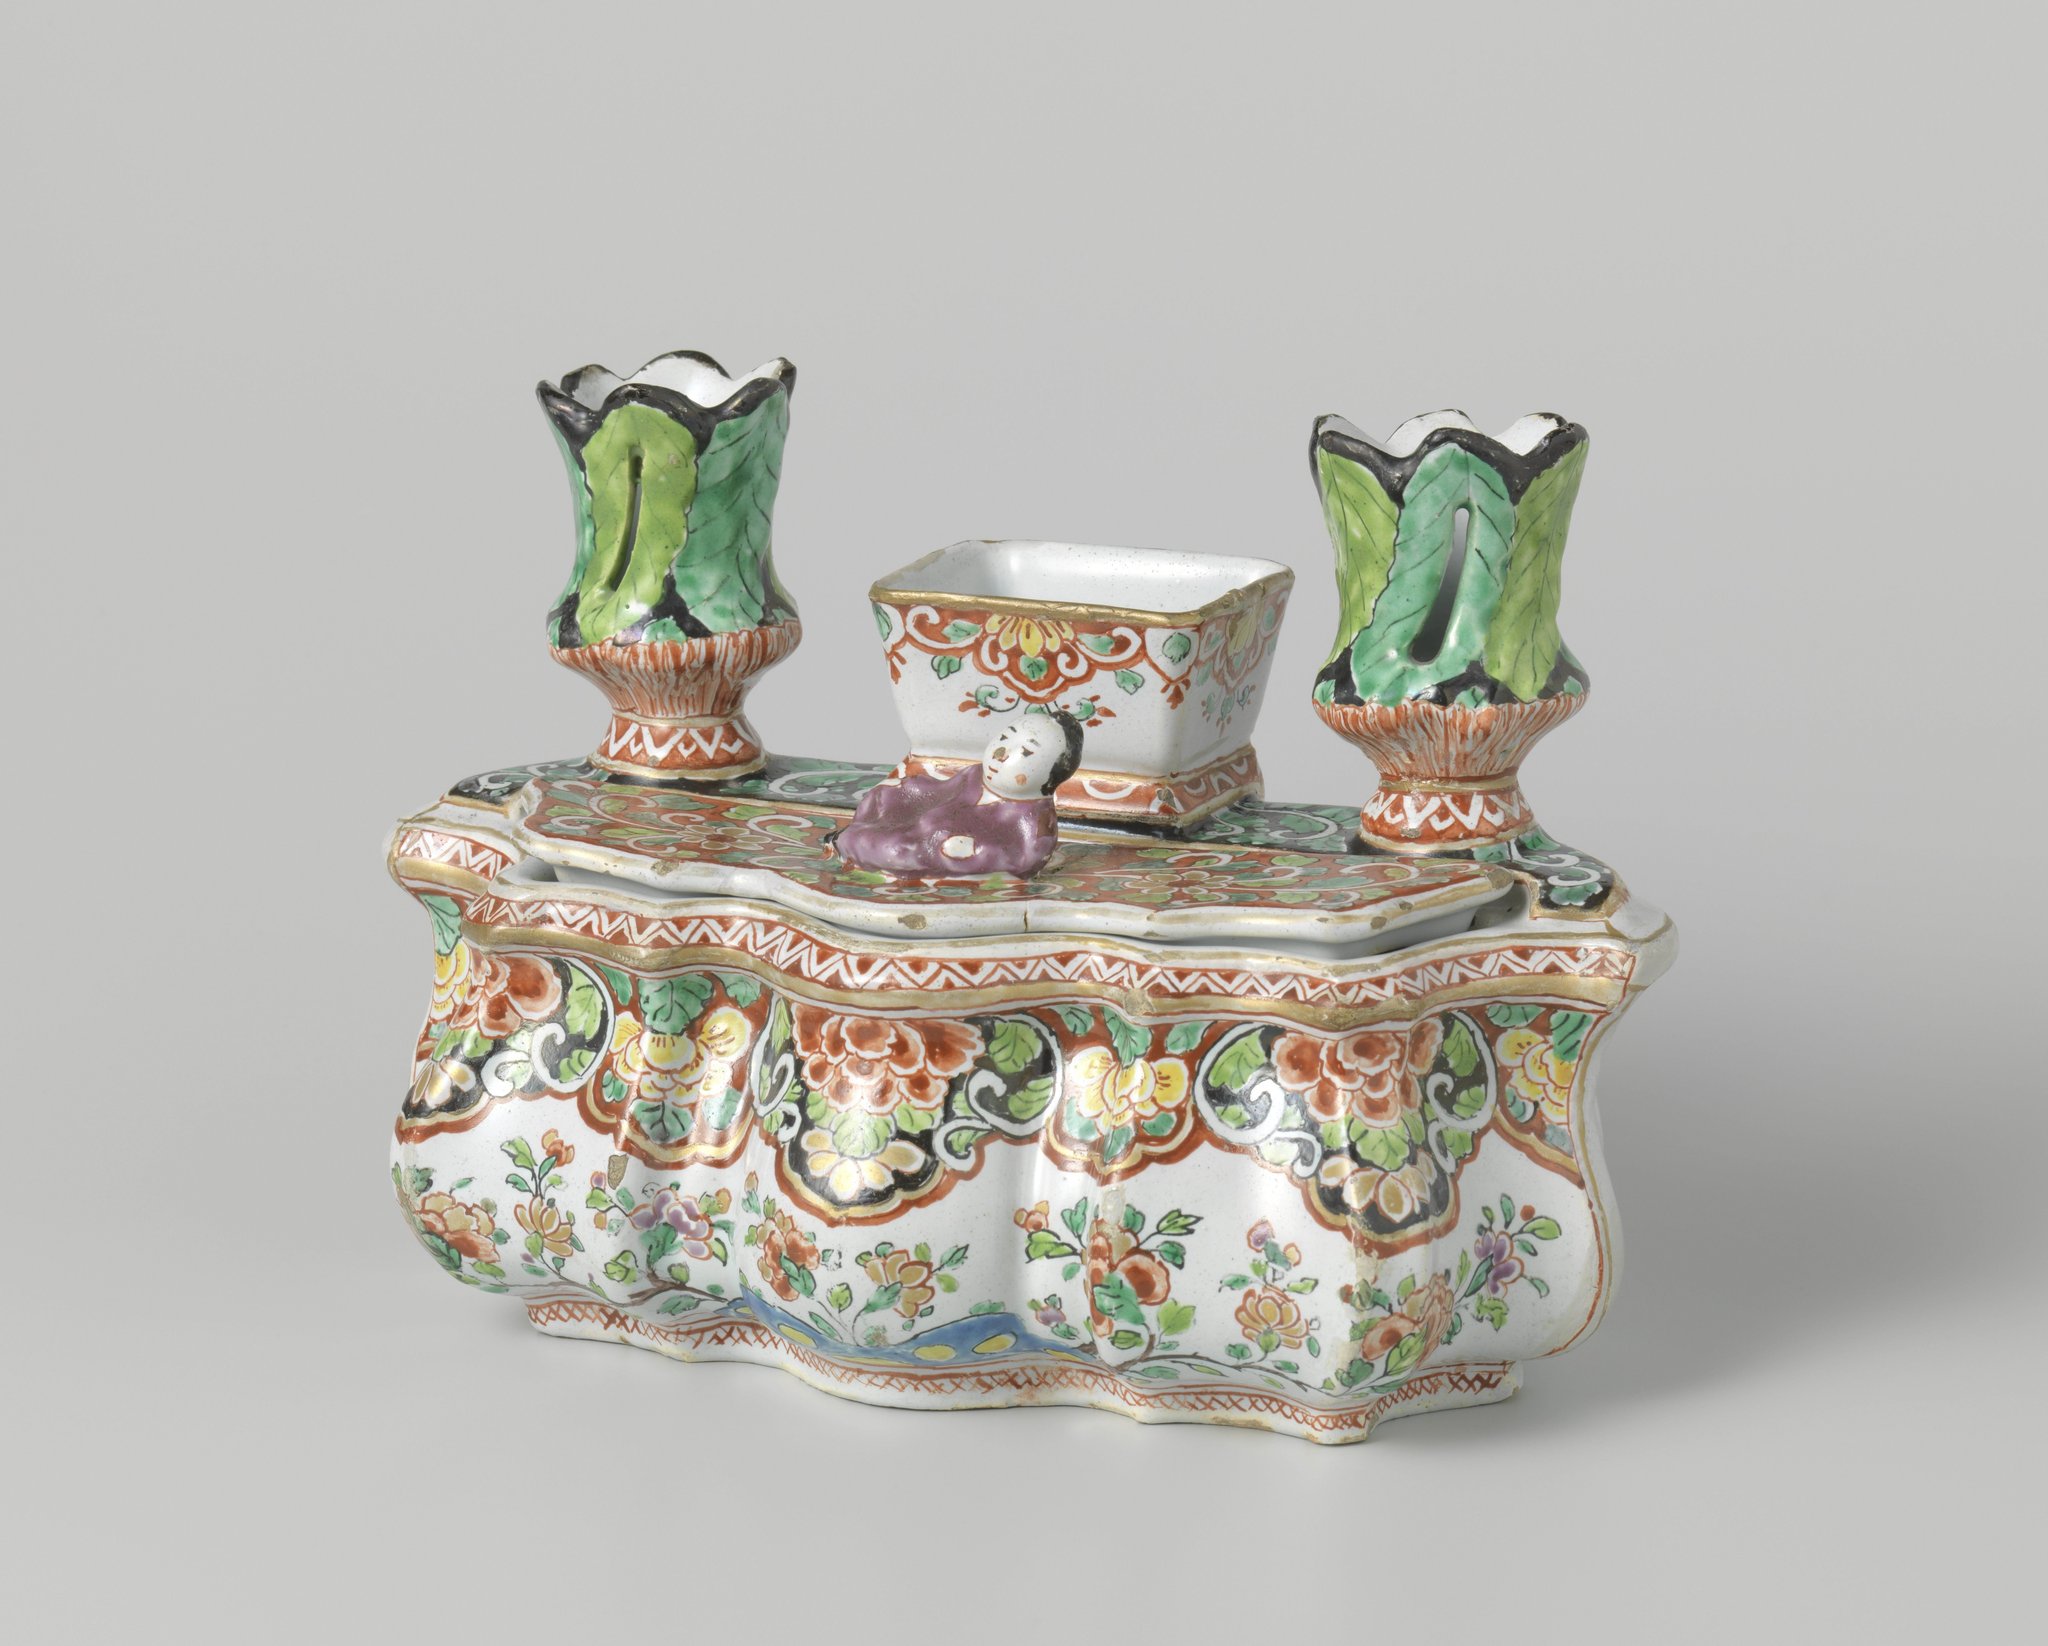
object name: inkstand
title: Inktstel van veelkleurig beschilderde faïence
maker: Anonymous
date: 1750-1775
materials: faience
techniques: kiln, painted, polychromy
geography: delft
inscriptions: collector's mark: ‘collection J.F. Loudon’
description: Langwerpig inktstel met bakje tussen twee kaarsenhouders. De veelkleurige beschildering bestaat uit lambrequins en bloemtakken.